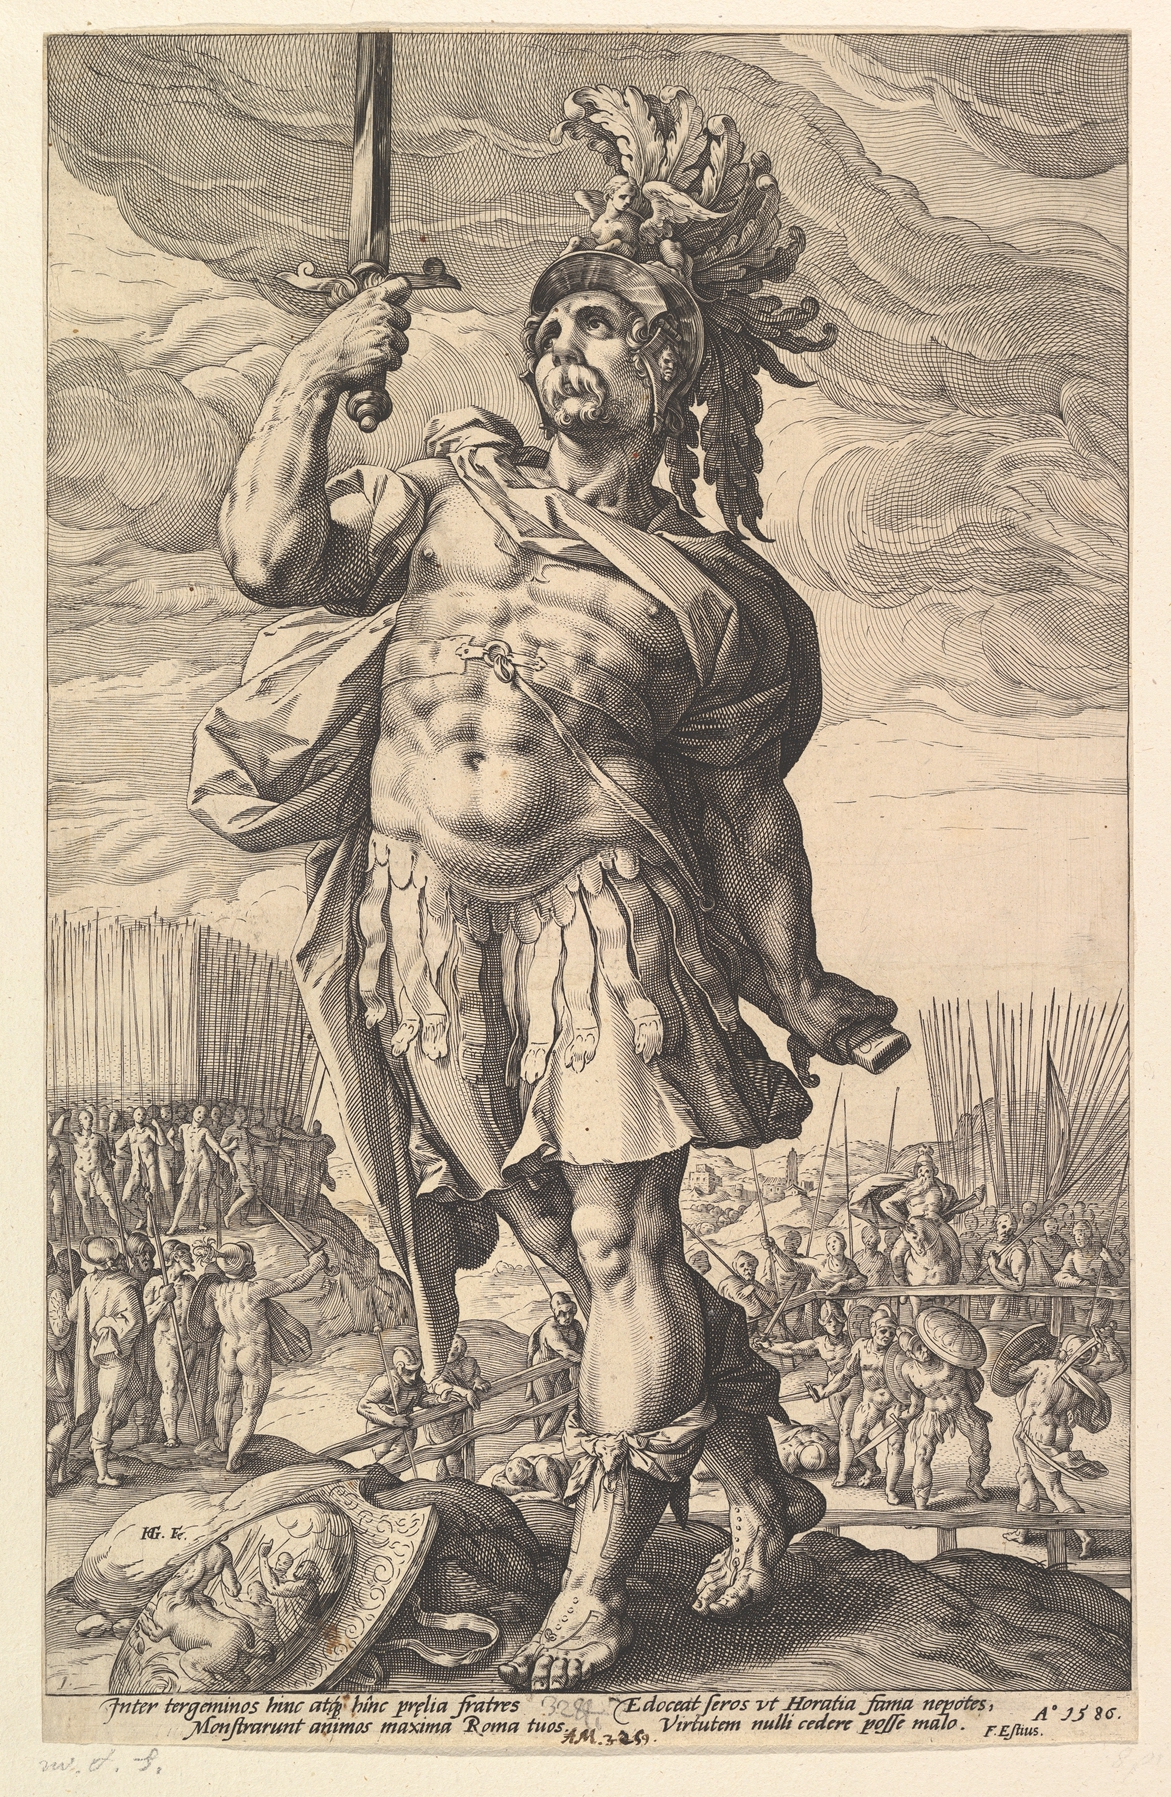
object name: print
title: Publius Horatius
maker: hendrick goltzius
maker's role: artist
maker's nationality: netherlandish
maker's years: 1558-1617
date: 1586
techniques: engraving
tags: swords,men,crowd